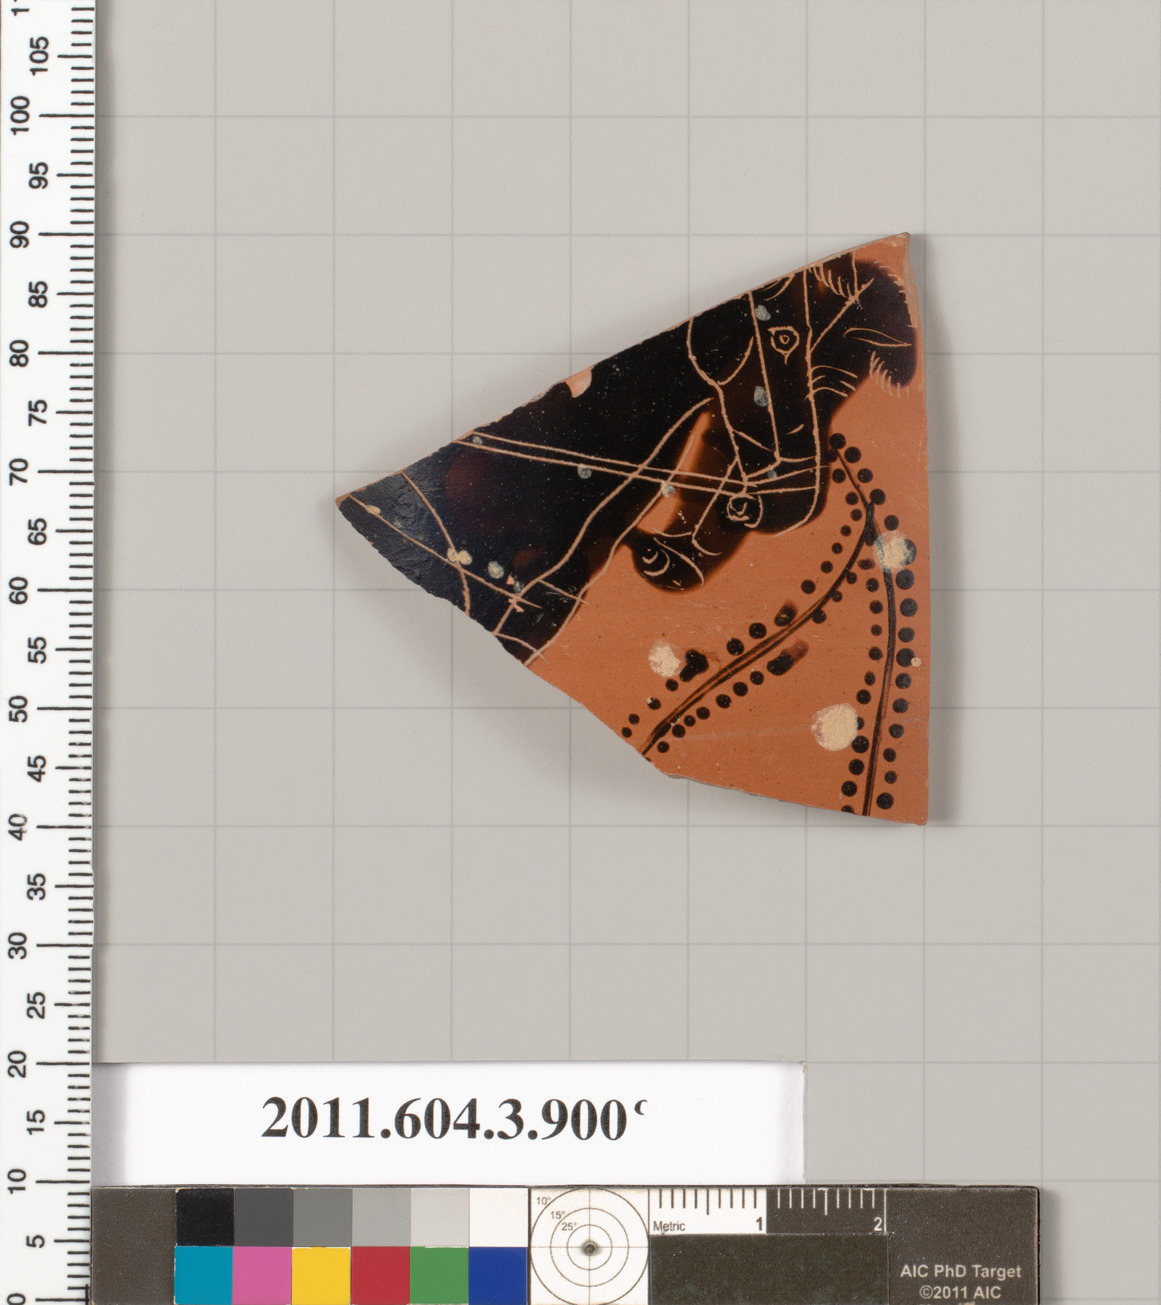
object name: lekythos fragment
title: Terracotta fragment of a lekythos (oil flask)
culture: greek, attic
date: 534-501 BCE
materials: terracotta